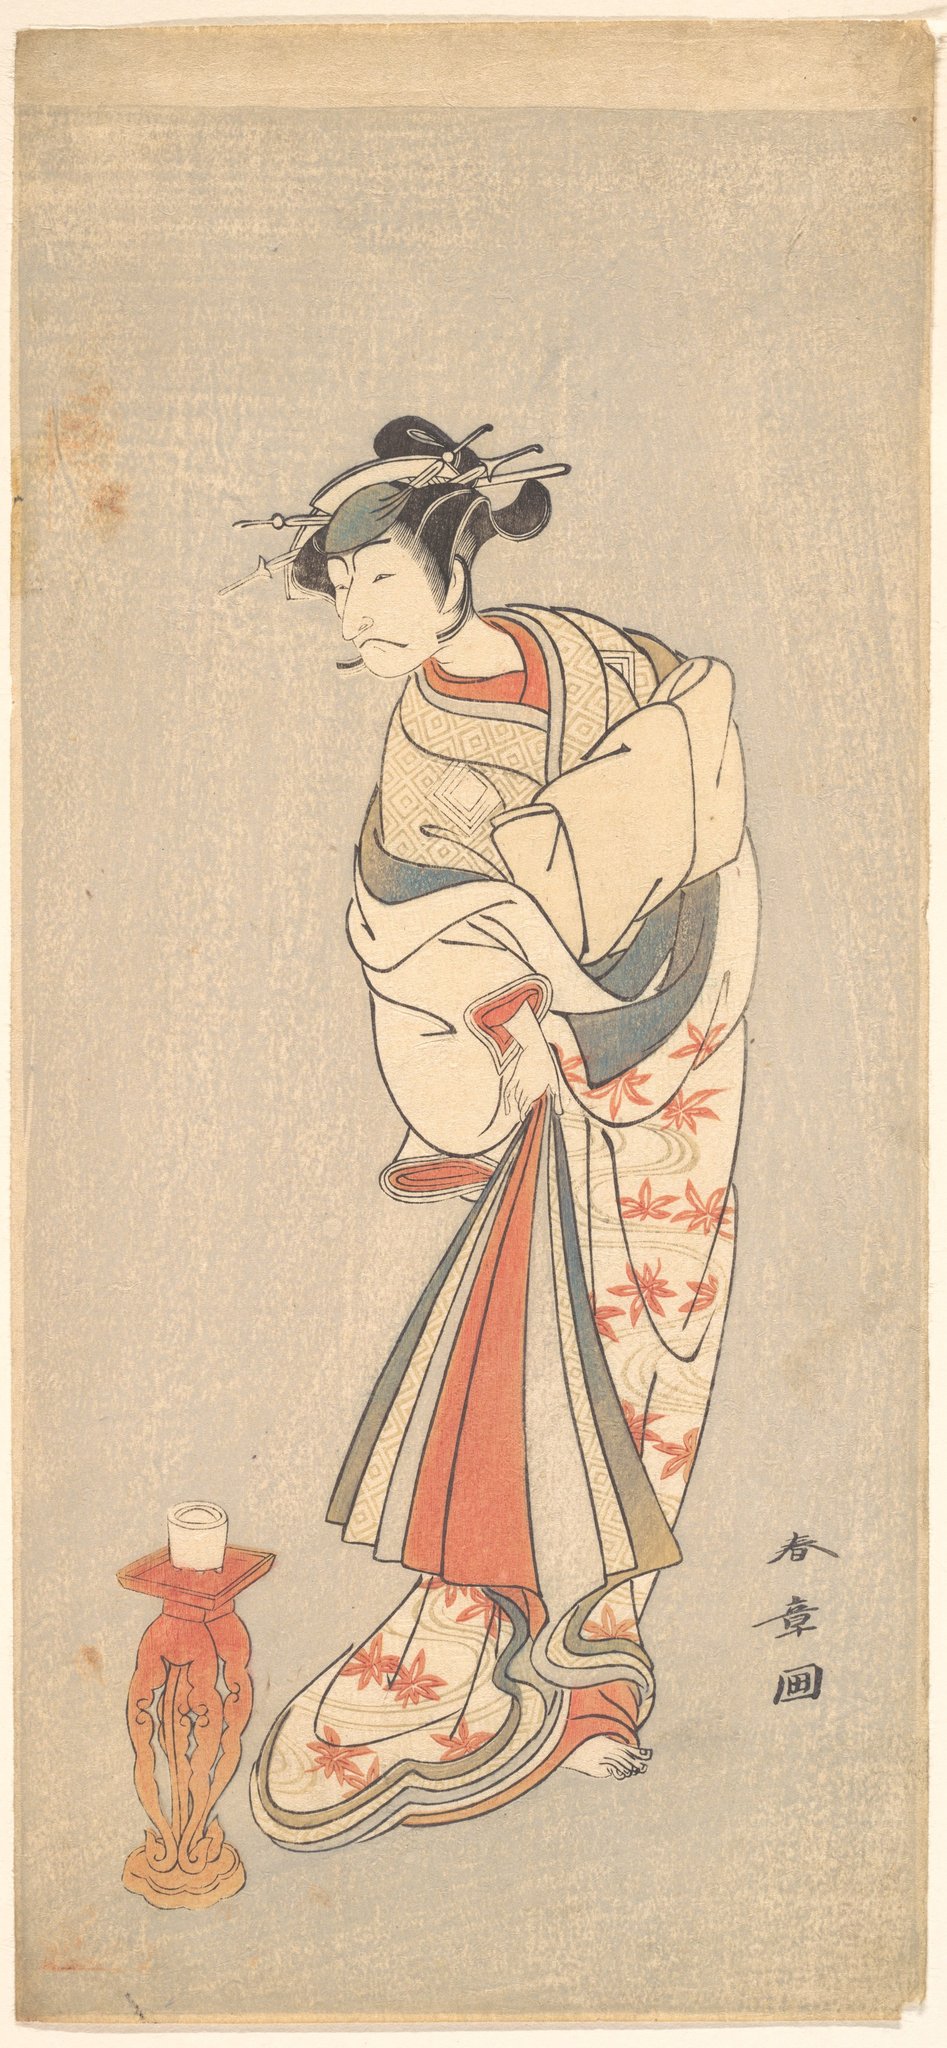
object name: woodblock print nishiki e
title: The Actor Ichikawa Danjuro V in the Role of a Woman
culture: japanese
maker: katsukawa shunshō 勝川春章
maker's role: artist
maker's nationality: japanese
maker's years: 1726-1792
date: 1772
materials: ink, paper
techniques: nishiki e, woodblock print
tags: women,actors